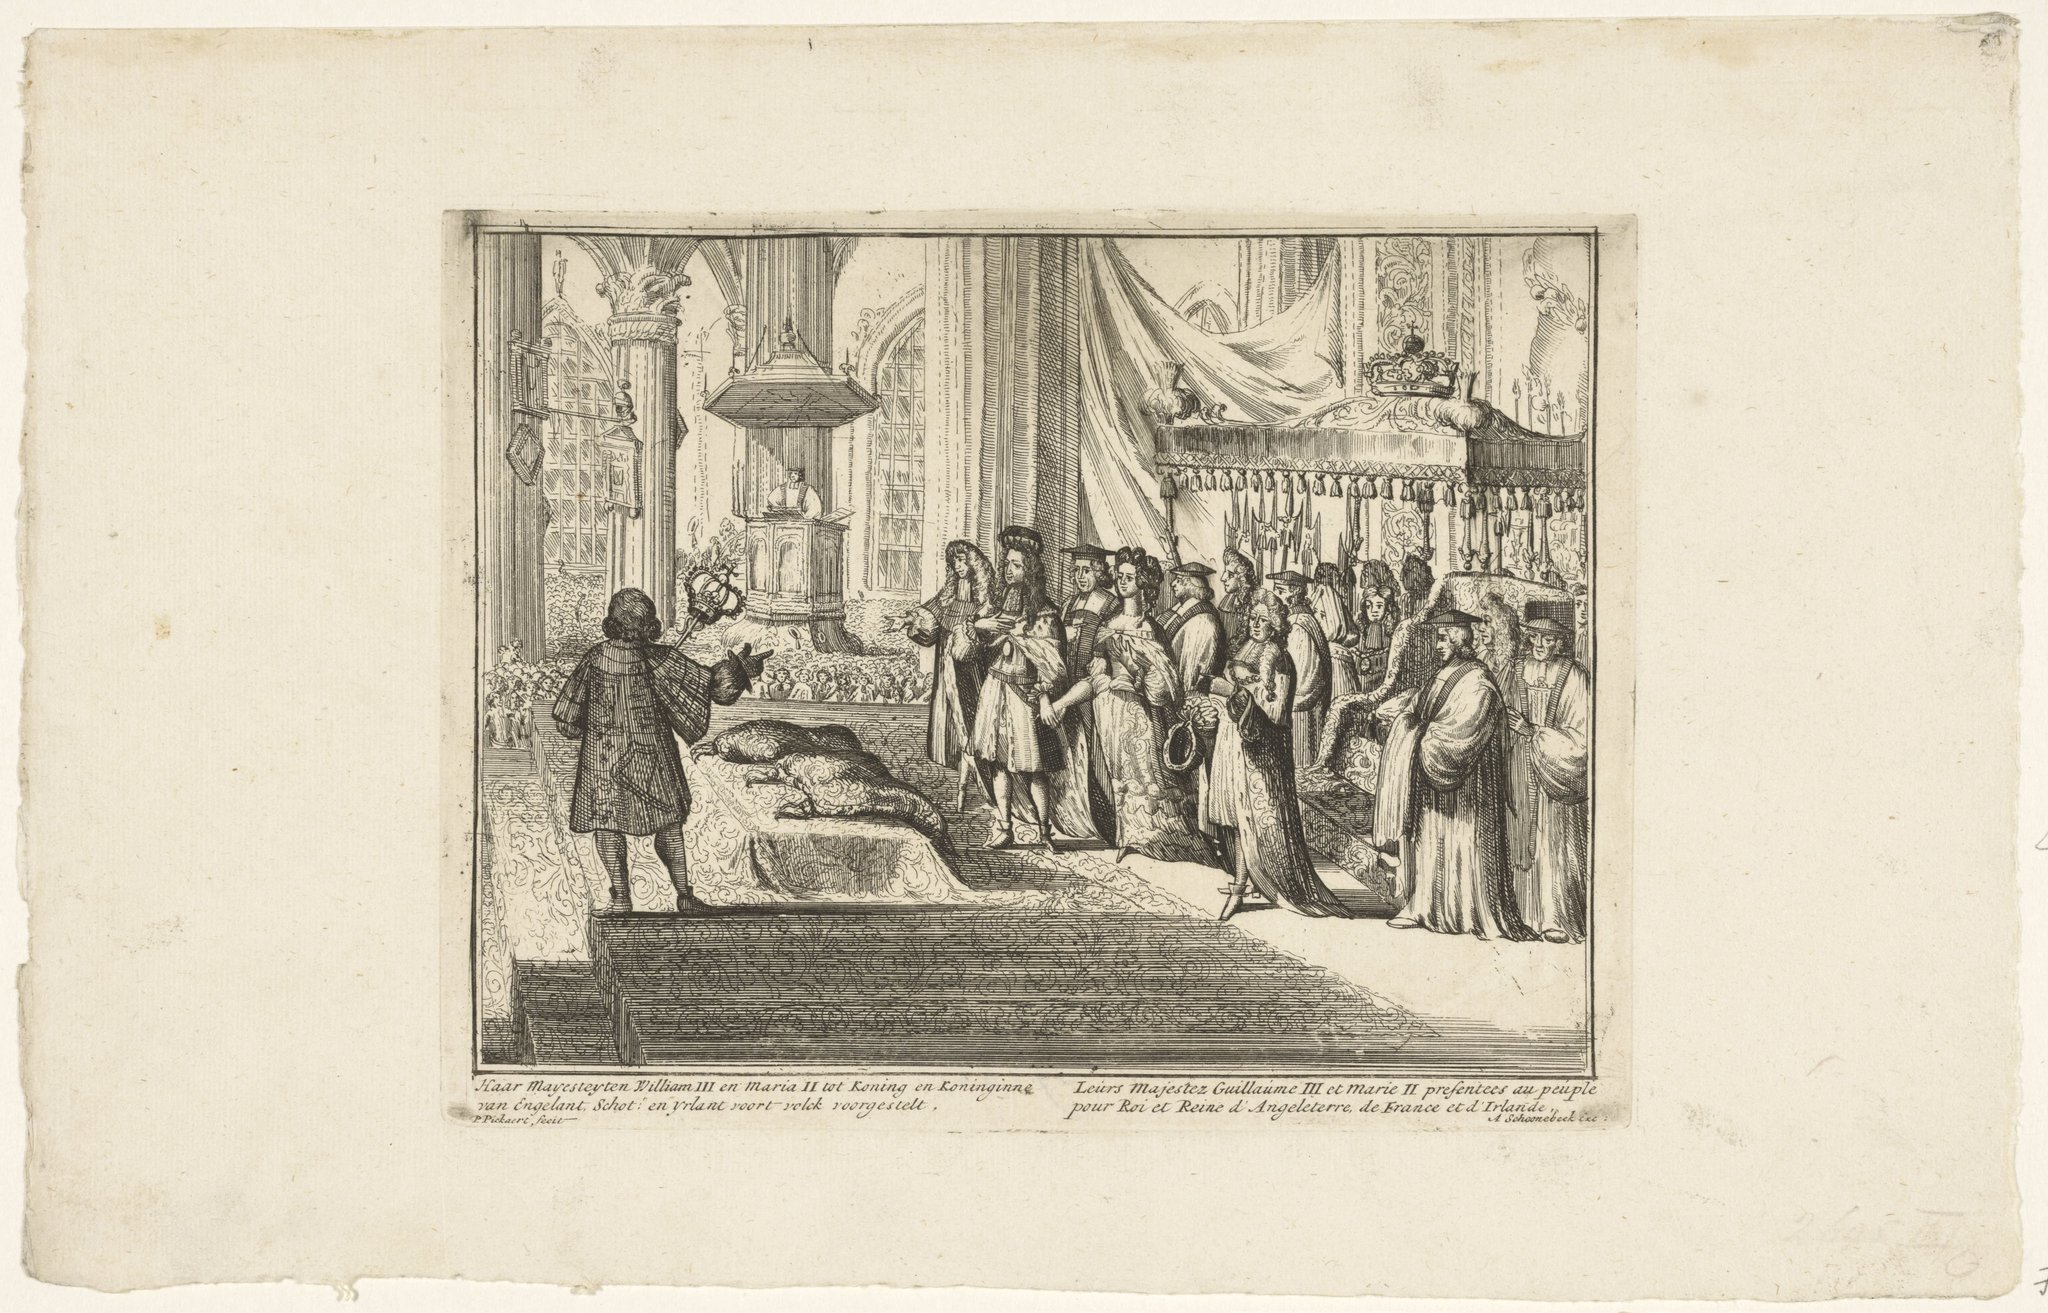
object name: print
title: Engelants schoutoneel verbeeldende de Glorieuse overtogt met het kroonen van William III en Maria II tot Koning en Koningin van groot Brittany en Vrankryk en Yrlant, etc. II Deel.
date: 1689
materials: paper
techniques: etching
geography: amsterdam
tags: the hague, william iii (prince of orange and king of england, scotland, and ireland), london, maria ii stuart (koningin van engeland, schotland en ierland), coronation of a ruler, westminster abbey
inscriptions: collector's mark: Lugt 2760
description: Het voorstellen aan het verzamelde volk in de Westminster Abbey van prins Willem III en prinses Maria als de nieuwe koning en koningin van Engeland, 21 april 1689. Onderdeel van de serie 'Engelants schouwtoneel' over de Glorious Revolution 1688-1689 (tweede deel). Met onderschriften in het Nederlands en Frans.